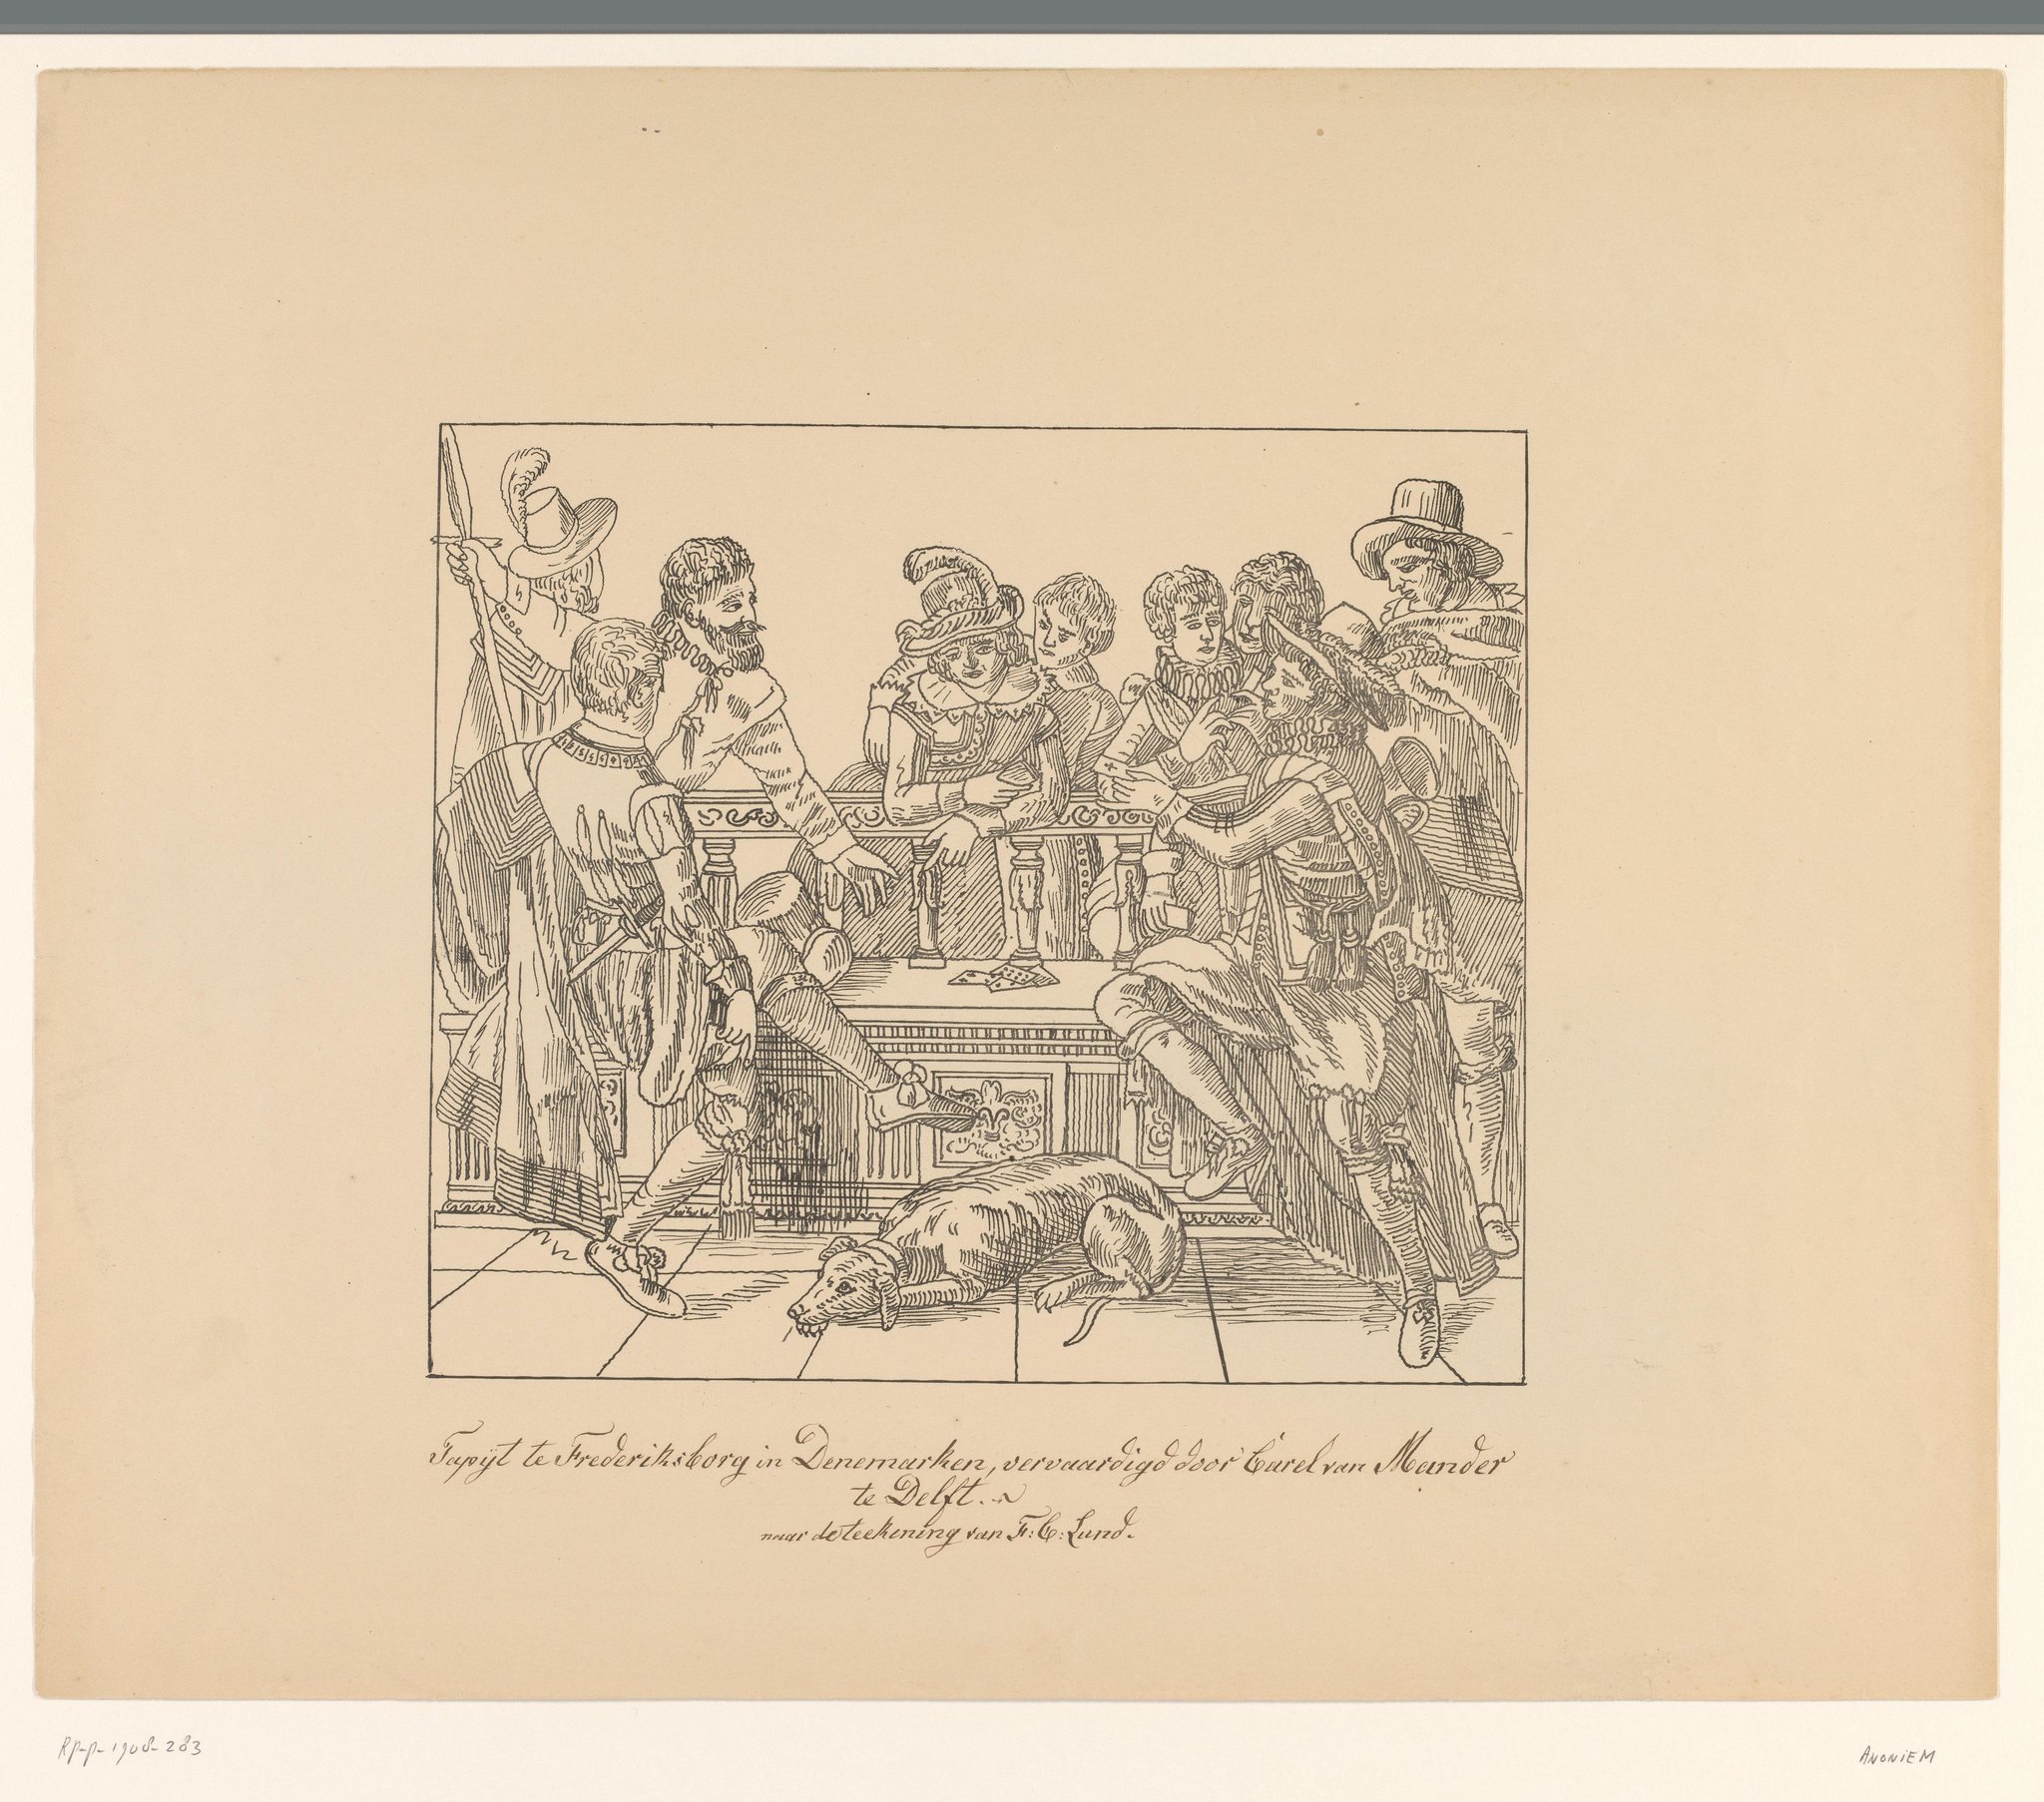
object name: print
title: Studie van tapijt te Frederiksborg in Denemarken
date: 1845-1908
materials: paper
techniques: lithograph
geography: netherlands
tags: playing-cards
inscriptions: collector's mark: Lugt 2228, inscription: ‘Tapijt te Frederiksborg in Denemarken, vervaardigd door Carel van Mander te Delft. naar de tekening van F.C. Lund.’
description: Studie van een tapijt dat in 1859 verloren is gegaan en oorspronkelijk bestemd was voor kasteel Frederiksborg. Karel van Mander maakte het ontwerp voor het tapijt, Heinrich Hansen maakte een tekening naar het tapijt en een onbekende lithograaf maakte naar de tekening deze lithografie.